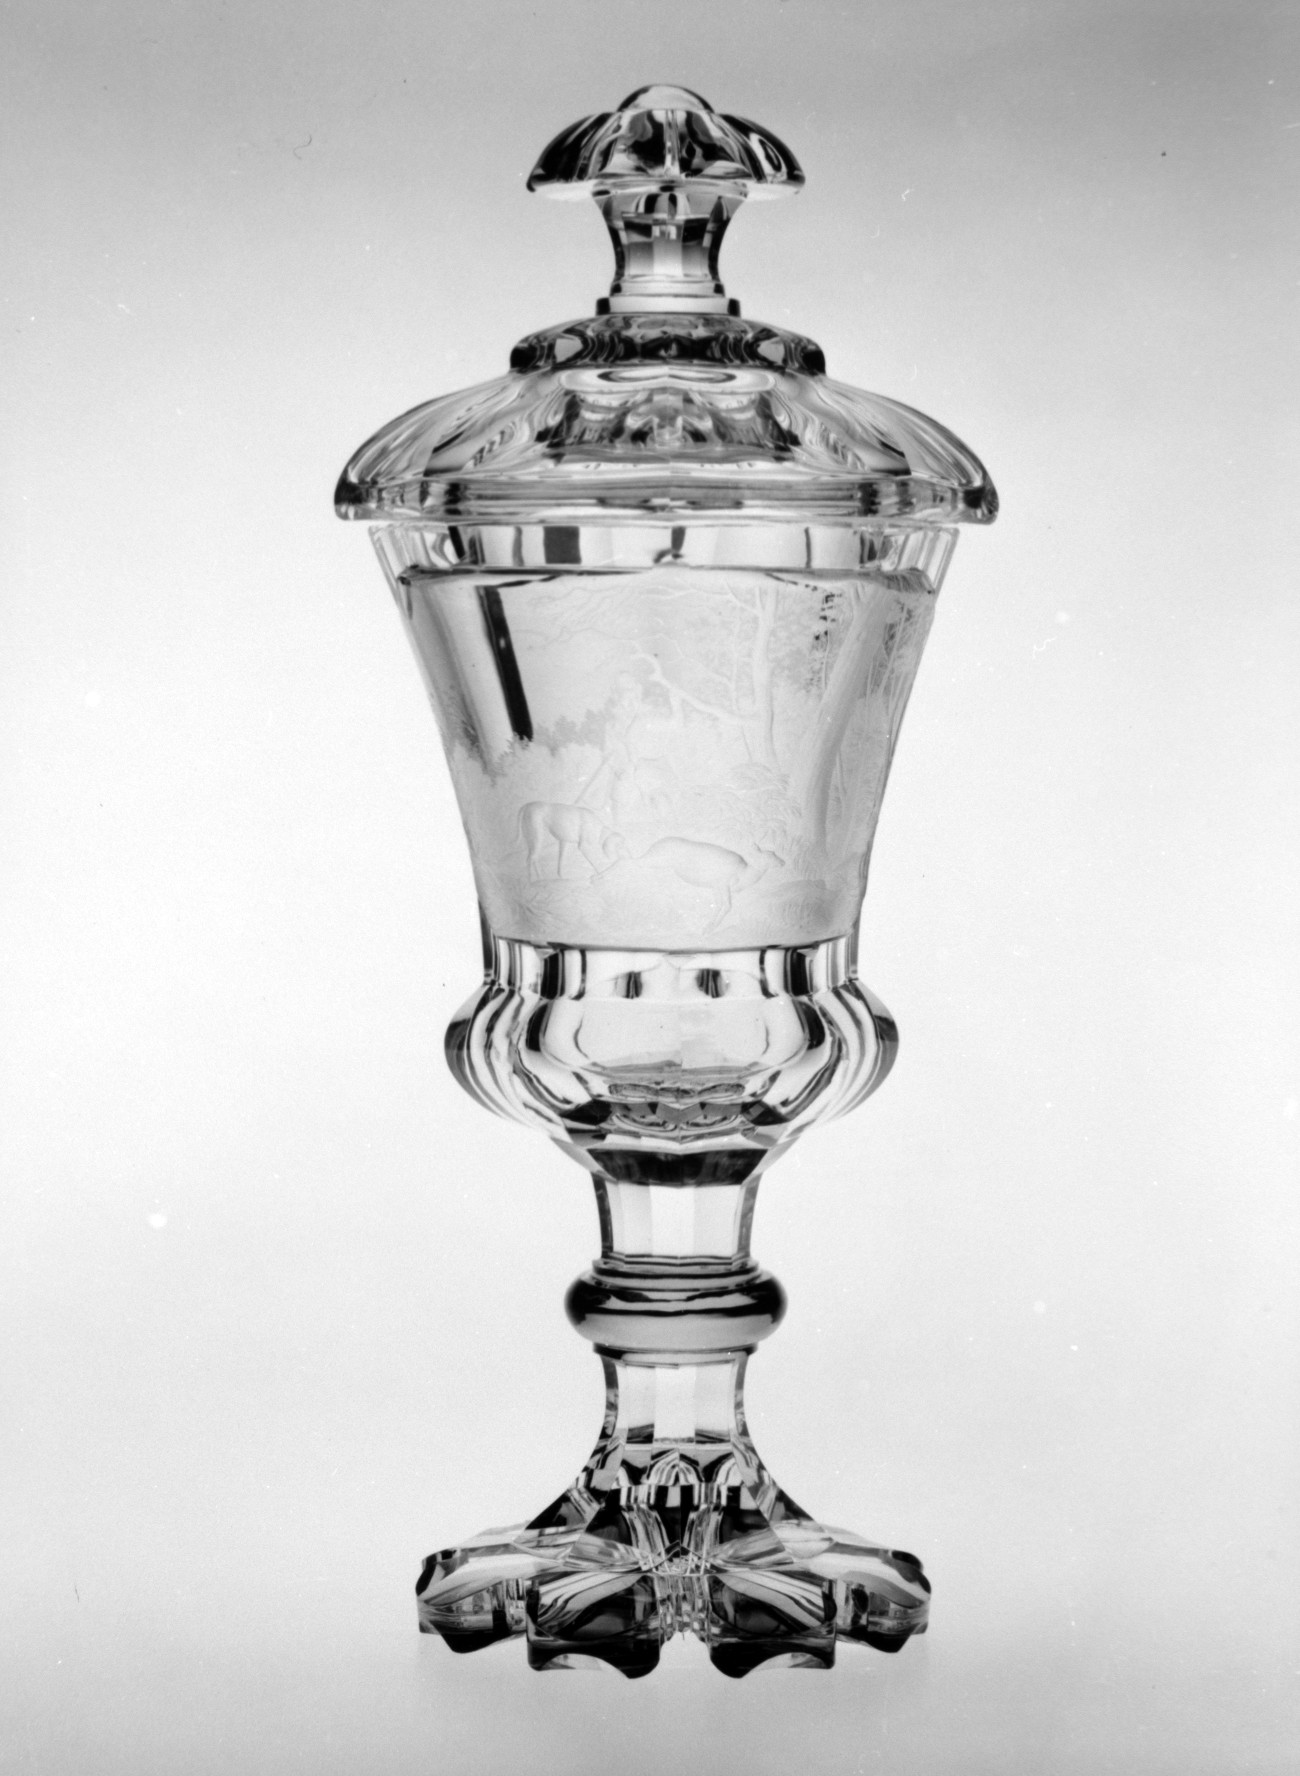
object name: standing cup with cover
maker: august böhm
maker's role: engraver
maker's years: 1812-1890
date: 1840-1850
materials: glass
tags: deer,trees